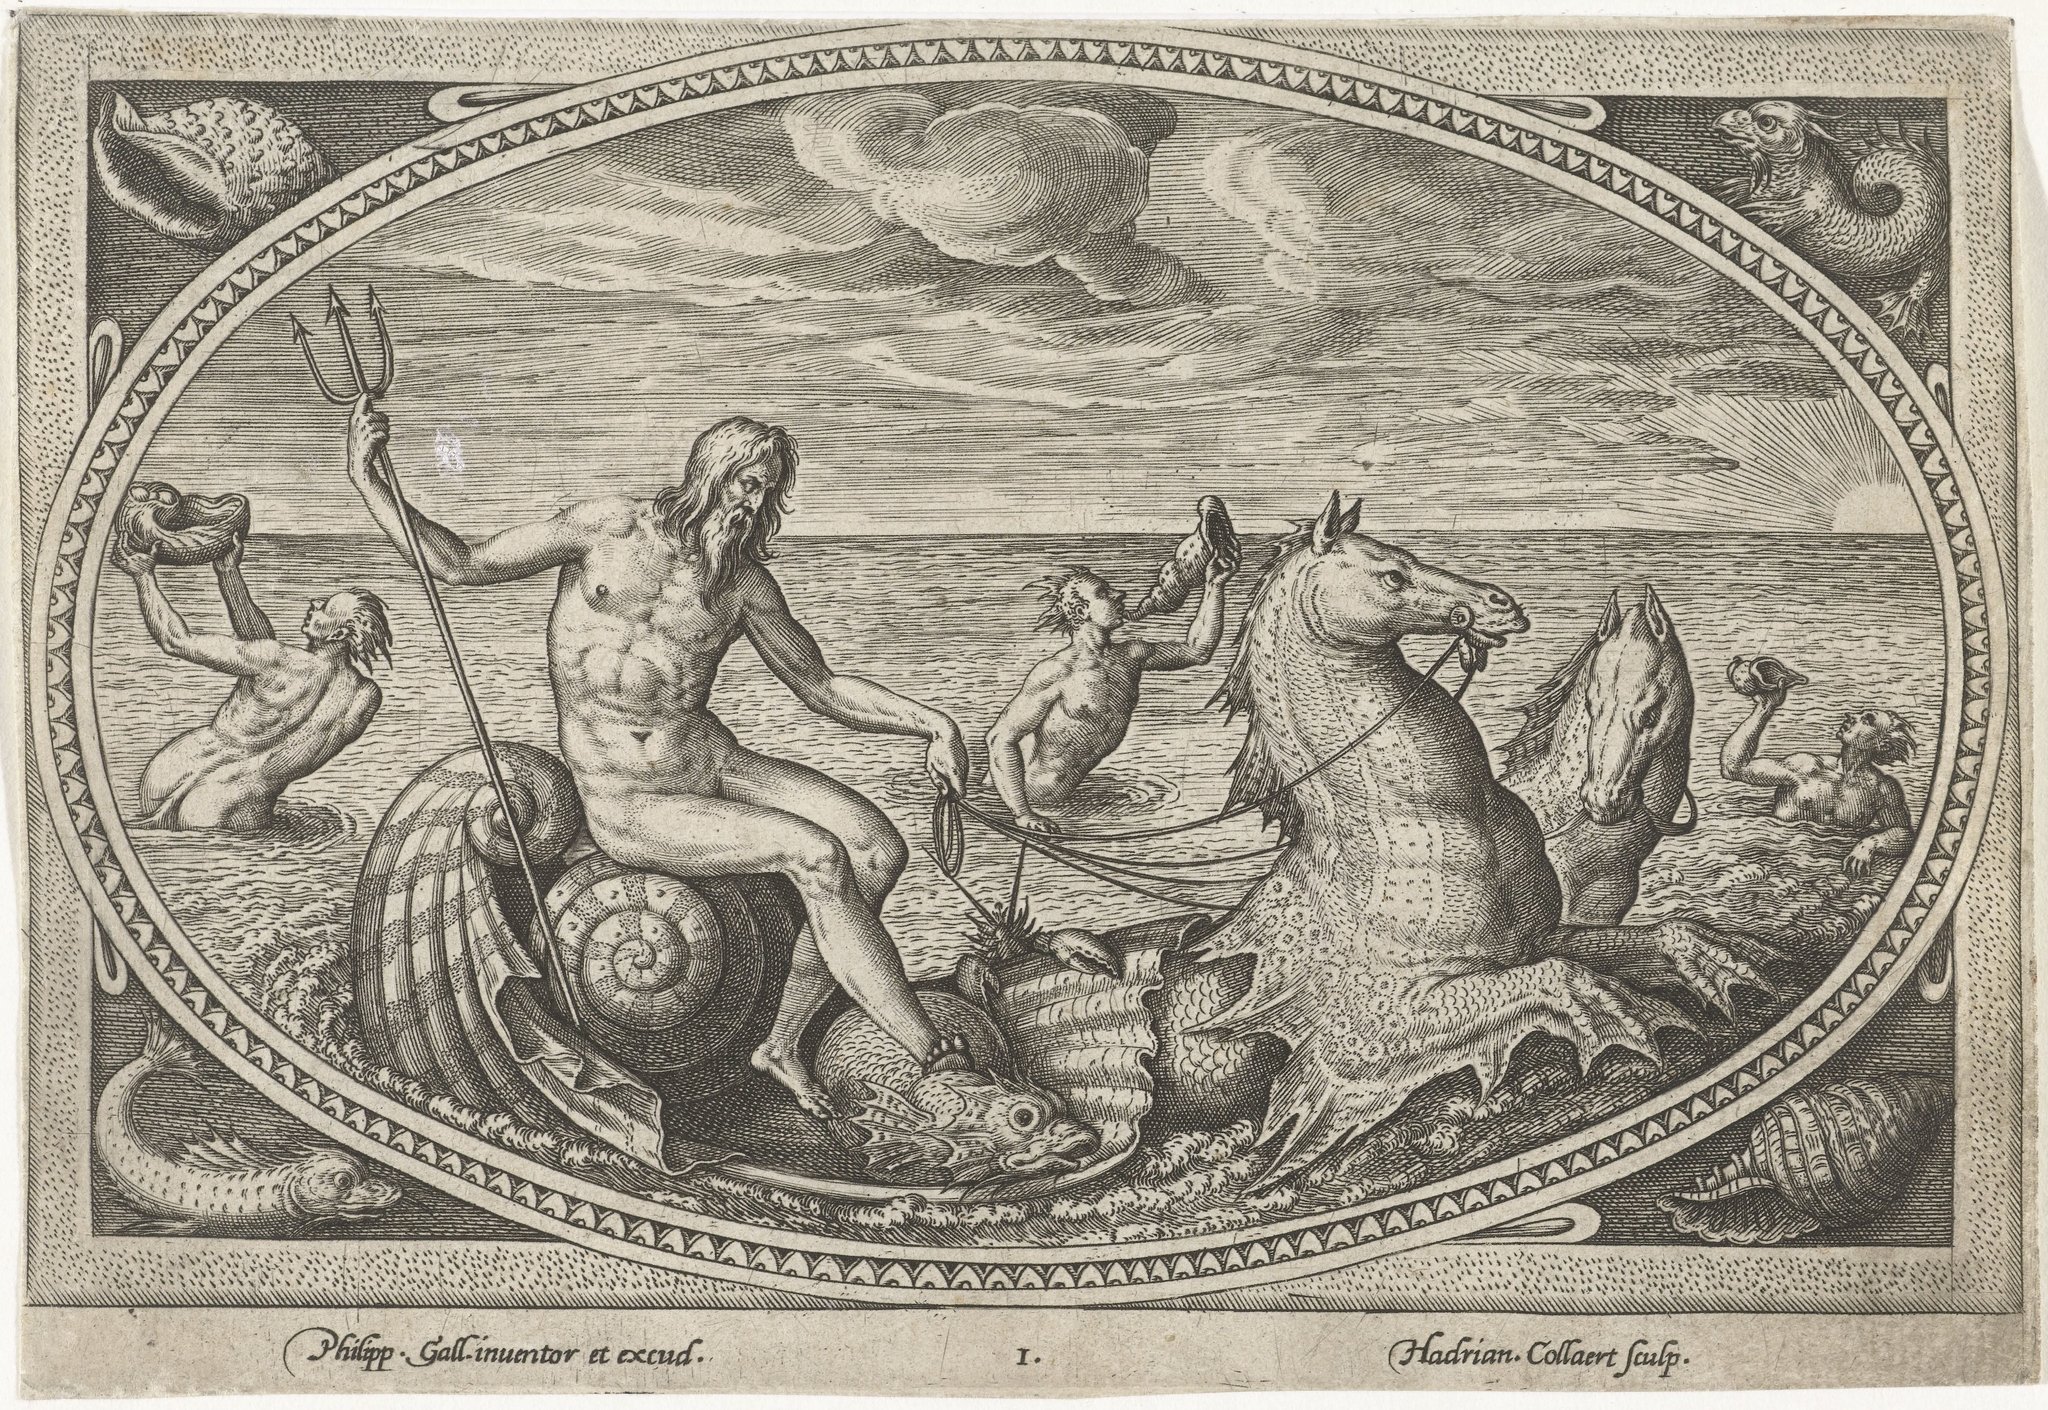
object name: print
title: Zeegoden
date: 1570-1618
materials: paper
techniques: engraving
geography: antwerp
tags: (story of) neptune (poseidon), sea-horse, hippocamp, 'hippocampus', (horse/fish) (mythological hybrid monster), merman, sea thiasos, neptune's sea retinue, attributes of neptune: trident, ichthyocentaur, centaurotriton, sea-centaur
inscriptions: collector's mark: Lugt 2760, collector's mark: Lugt 2228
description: In een ovale lijst de zee met Neptunus, in een grote zeeschelp, voortgetrokken door twee hippocampussen (zeepaarden). Hij heeft zijn drietand in de hand. Rondom hem drie meermannen die elk blazen op een tritonshoren. De prent is deel van een vierdelige serie over mythologische zeegoden.